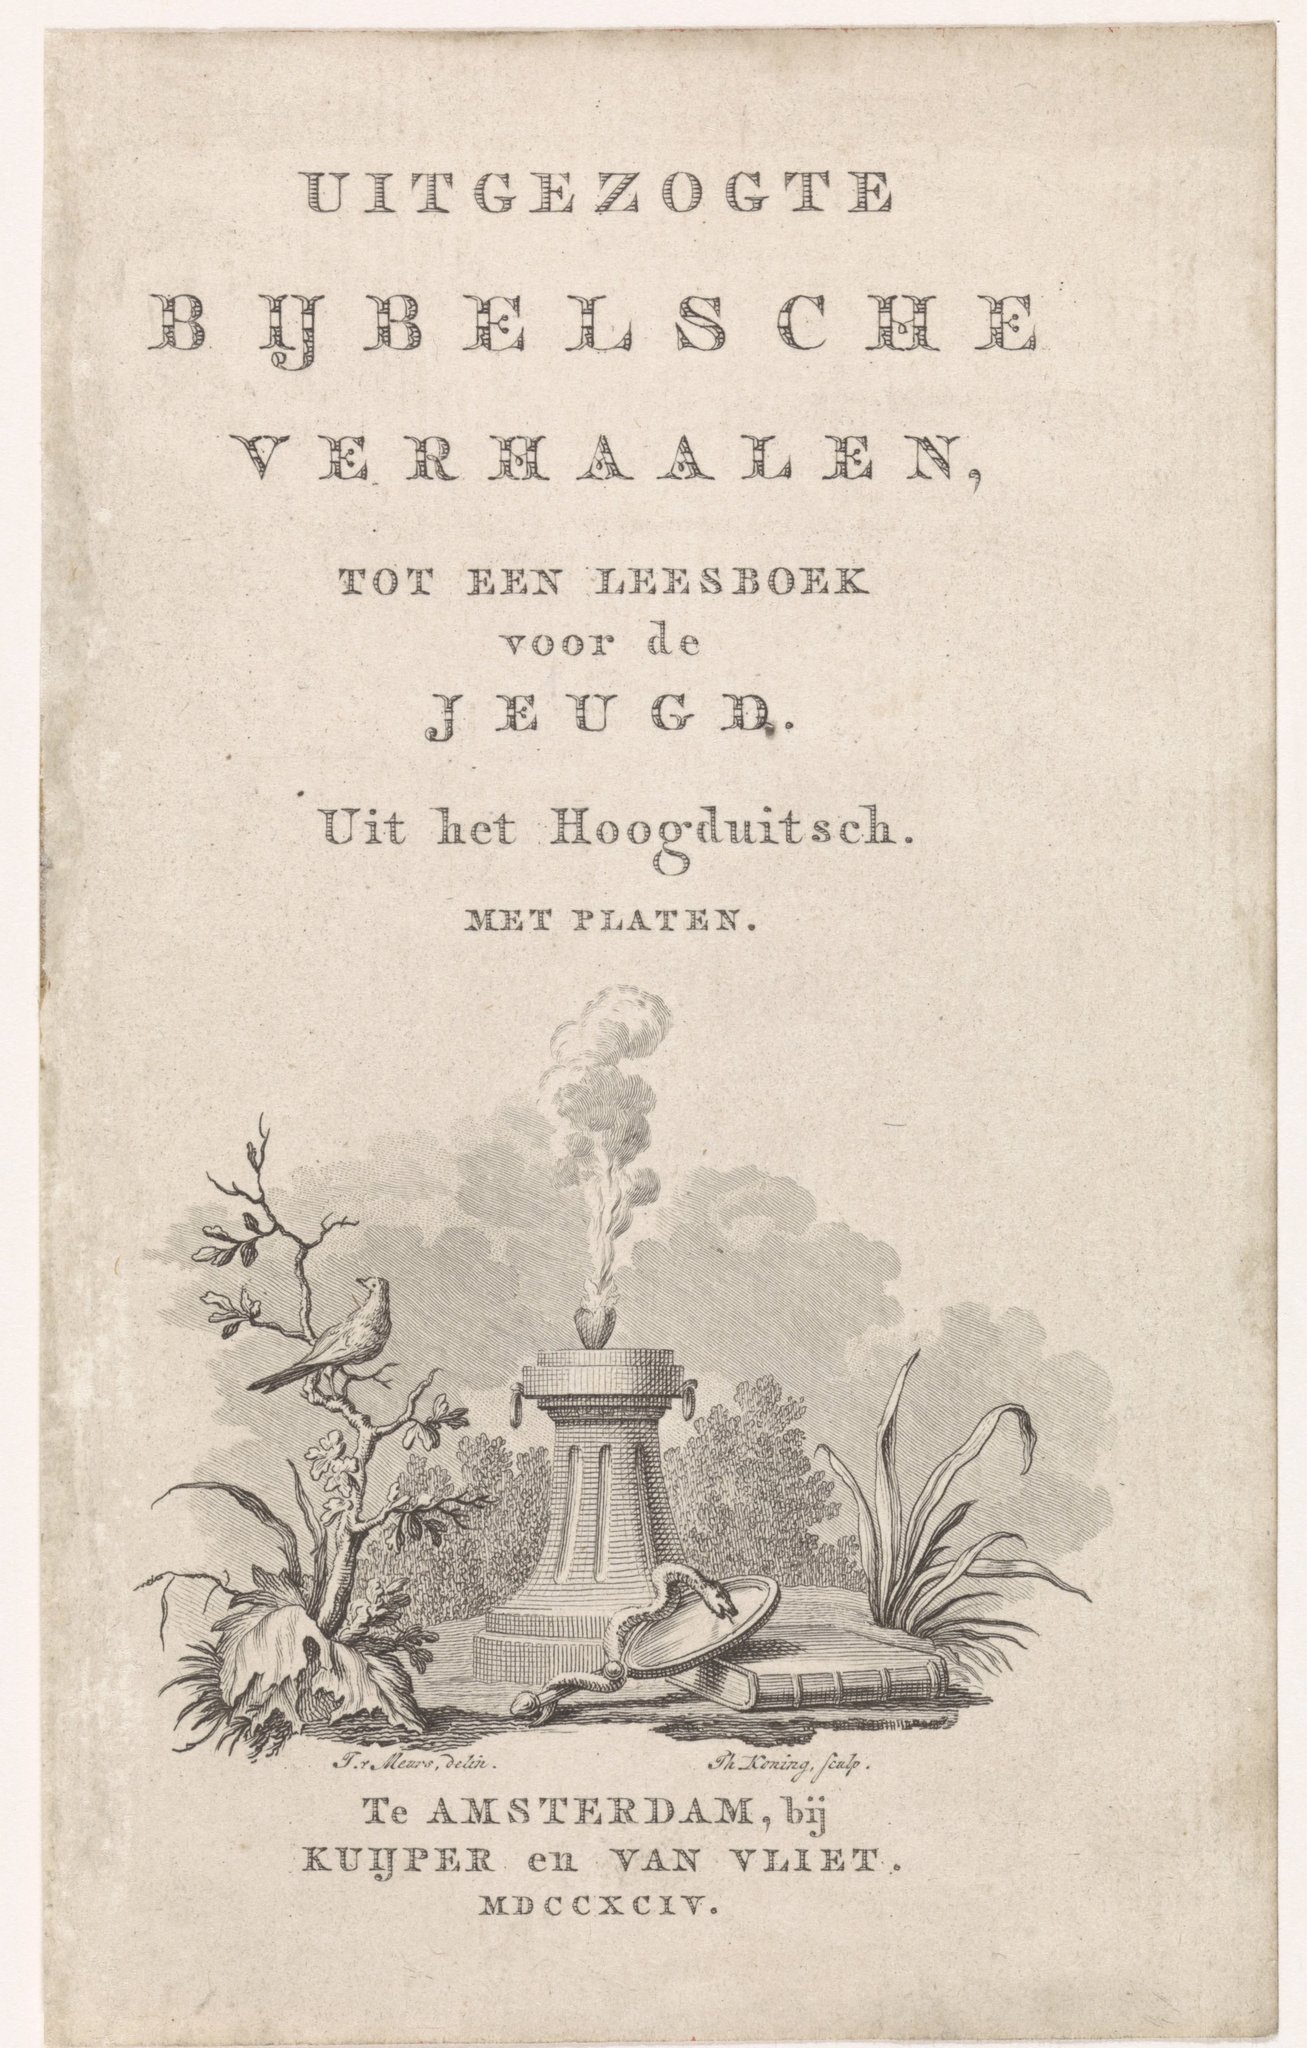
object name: print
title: Taferelen uit de bijbel voor de jeugd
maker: theodoor koning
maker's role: print maker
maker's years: 1748-1829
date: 1794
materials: paper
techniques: etching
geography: amsterdam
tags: snakes, birds, mirror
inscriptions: collector's mark: Lugt 2228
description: Onder de titel een vogel op een tak, een brandend hart, een slang bij een spiegel en een boek. Deze prent is de titelpagina voor het boek 'Uitgezogte bĳbelsche verhaalen, tot een leesboek voor de jeugd'.